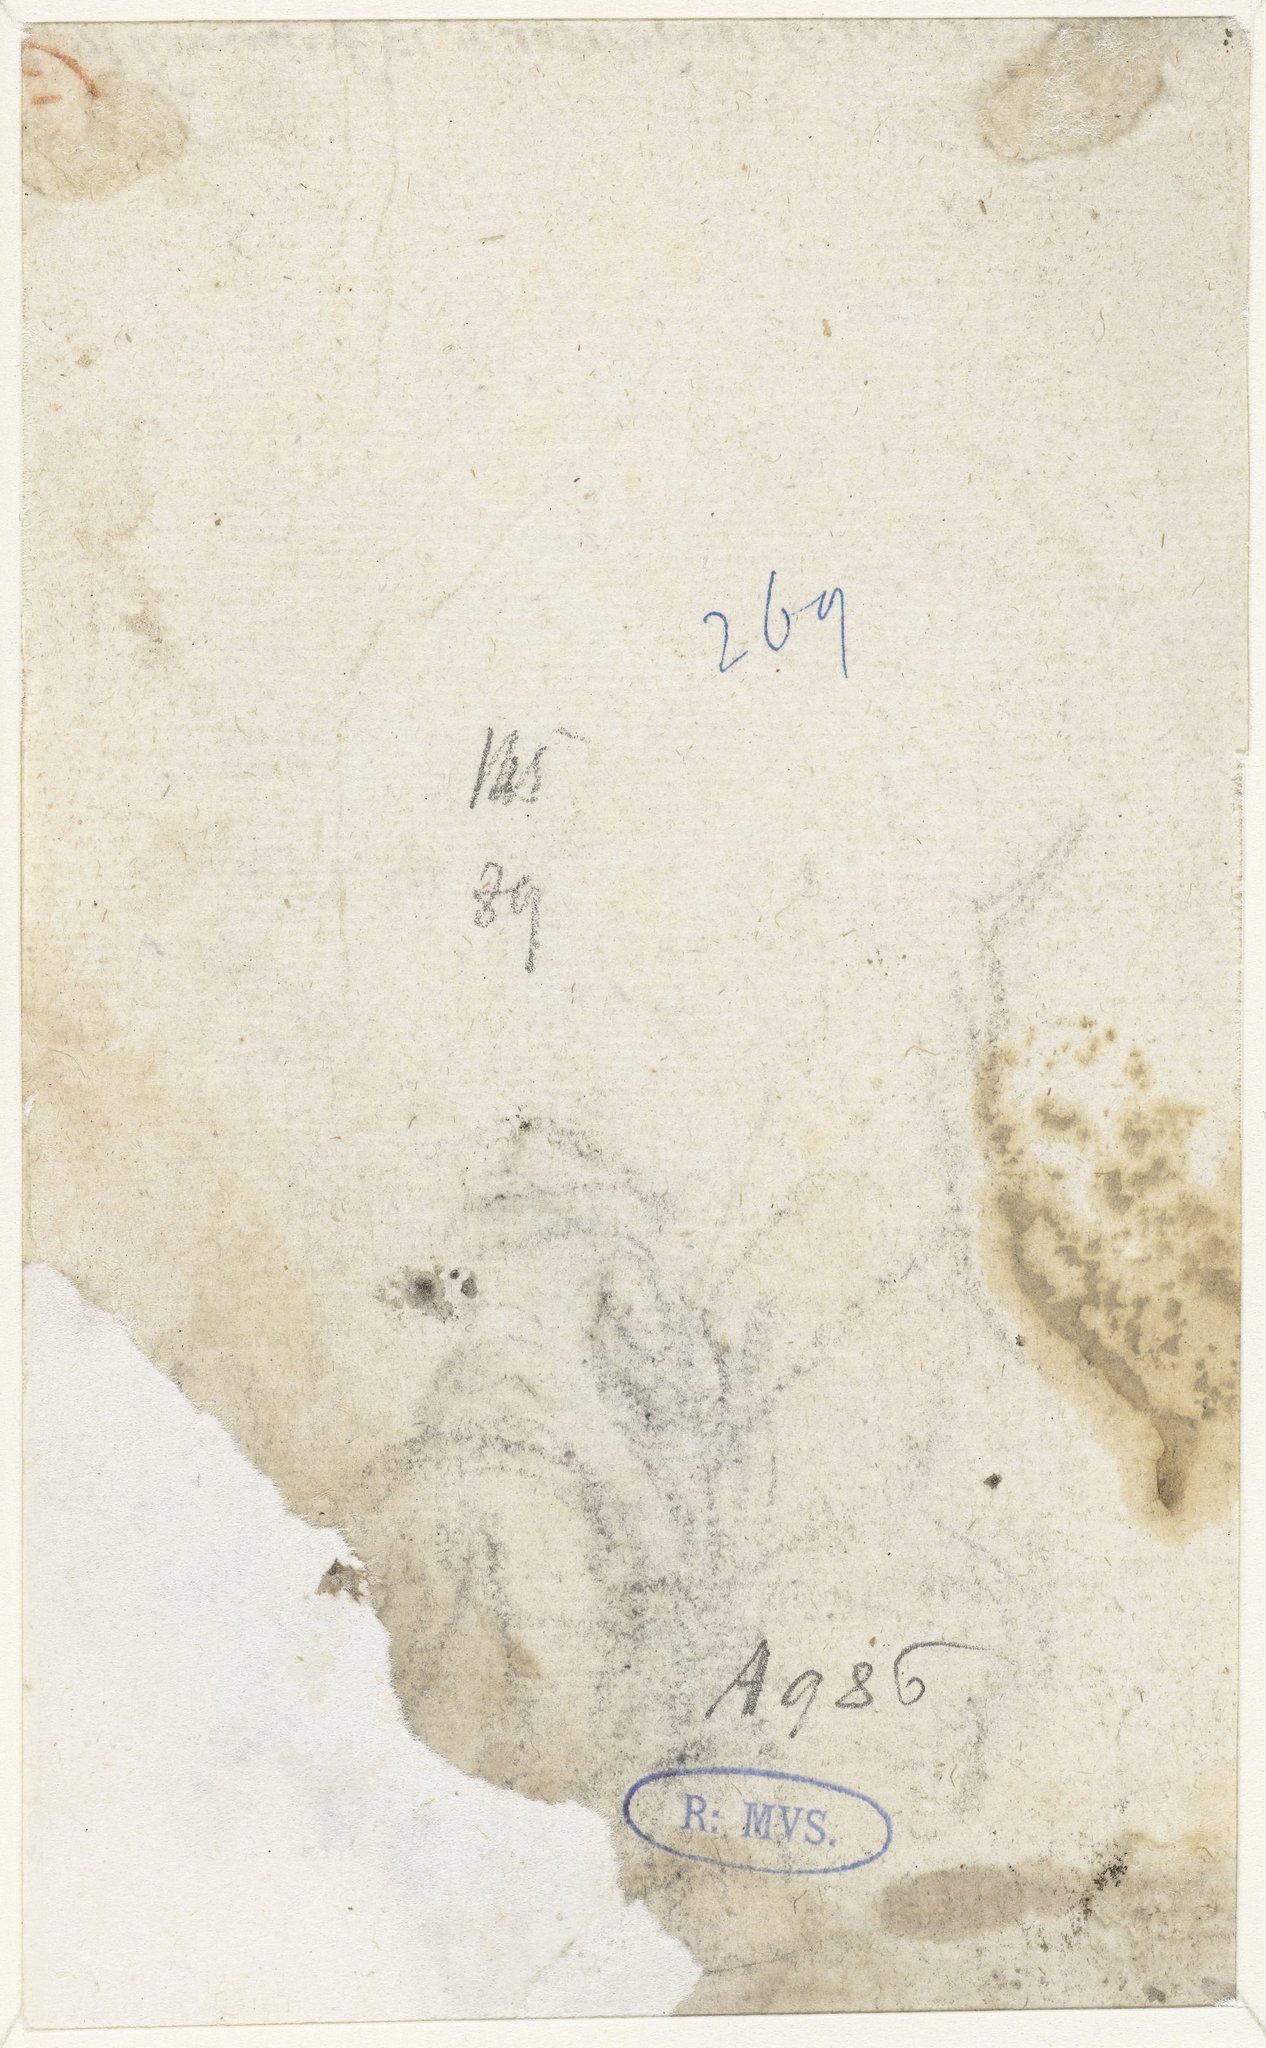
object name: drawing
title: Ruiter te paard in een landschap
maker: harmen ter borch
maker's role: draughtsman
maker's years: 1638-1677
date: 1651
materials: chalk, paper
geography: zwolle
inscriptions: date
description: Overgetrokken van de voorzijde (in spiegelbeeld).